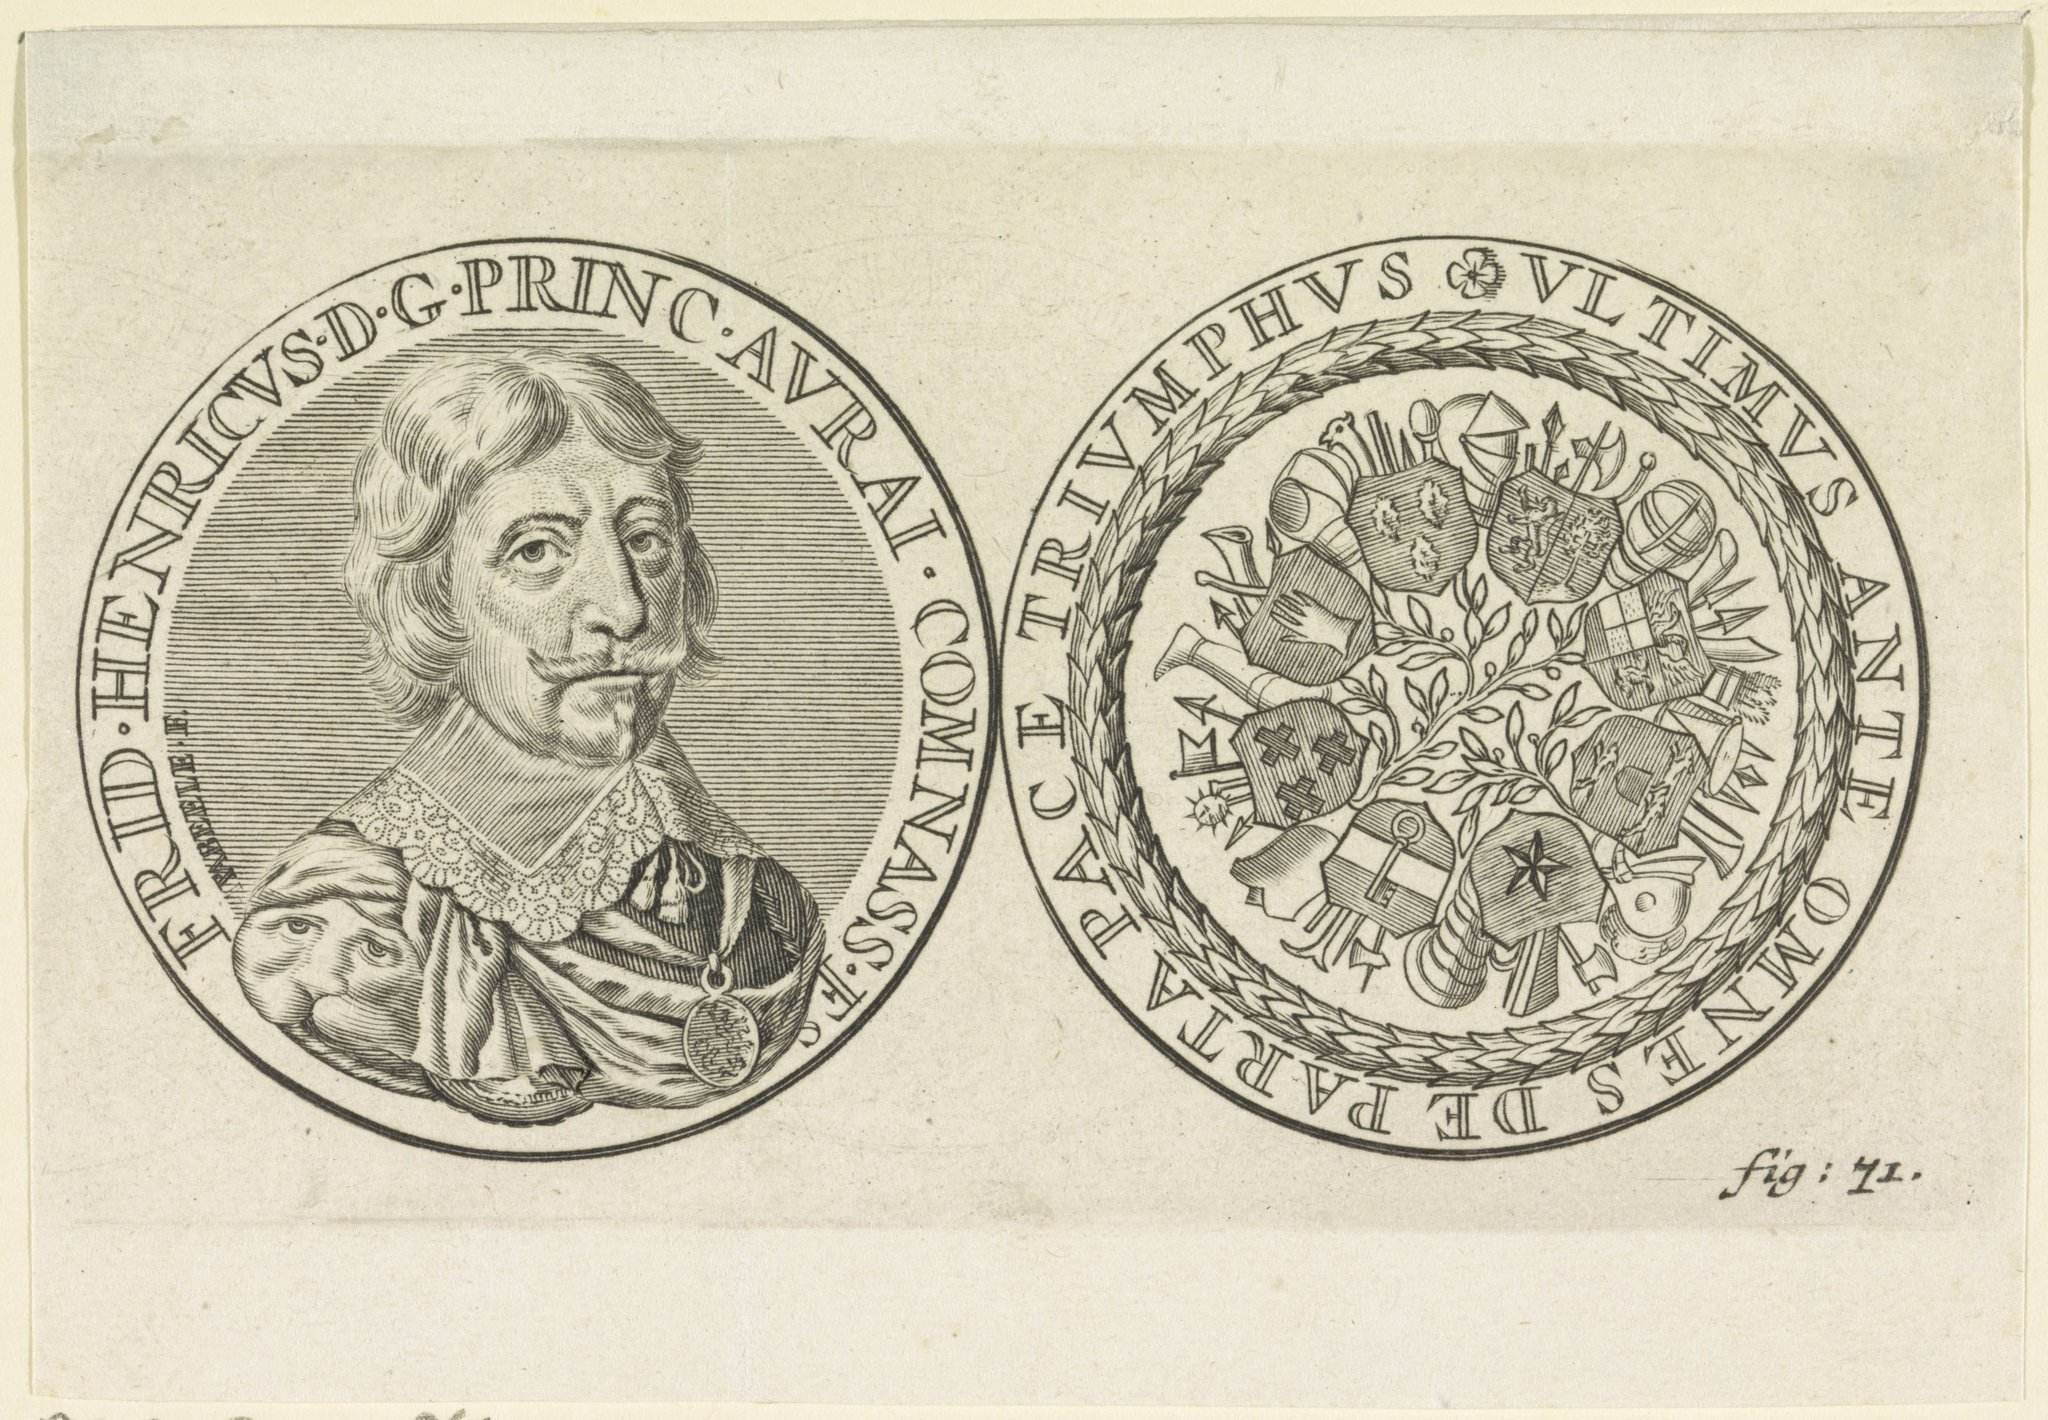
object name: book illustration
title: Penning met portret van Frederik Hendrik, prins van Oranje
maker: Anonymous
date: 1700-1799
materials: paper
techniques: engraving, etching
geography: low countries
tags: frederick henry (prince of orange), knighthood order (garter) - insignia of a knighthood order, e.g.: badge, chain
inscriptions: collector's mark: Lugt 963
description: Portret van Frederik Hendrik in een cirkel met randschrift links. Wapens, oranjetakken en een aantal allegorische objecten in een cirkel met randschrift rechts. Rechtsonder 'fig: 71.'.